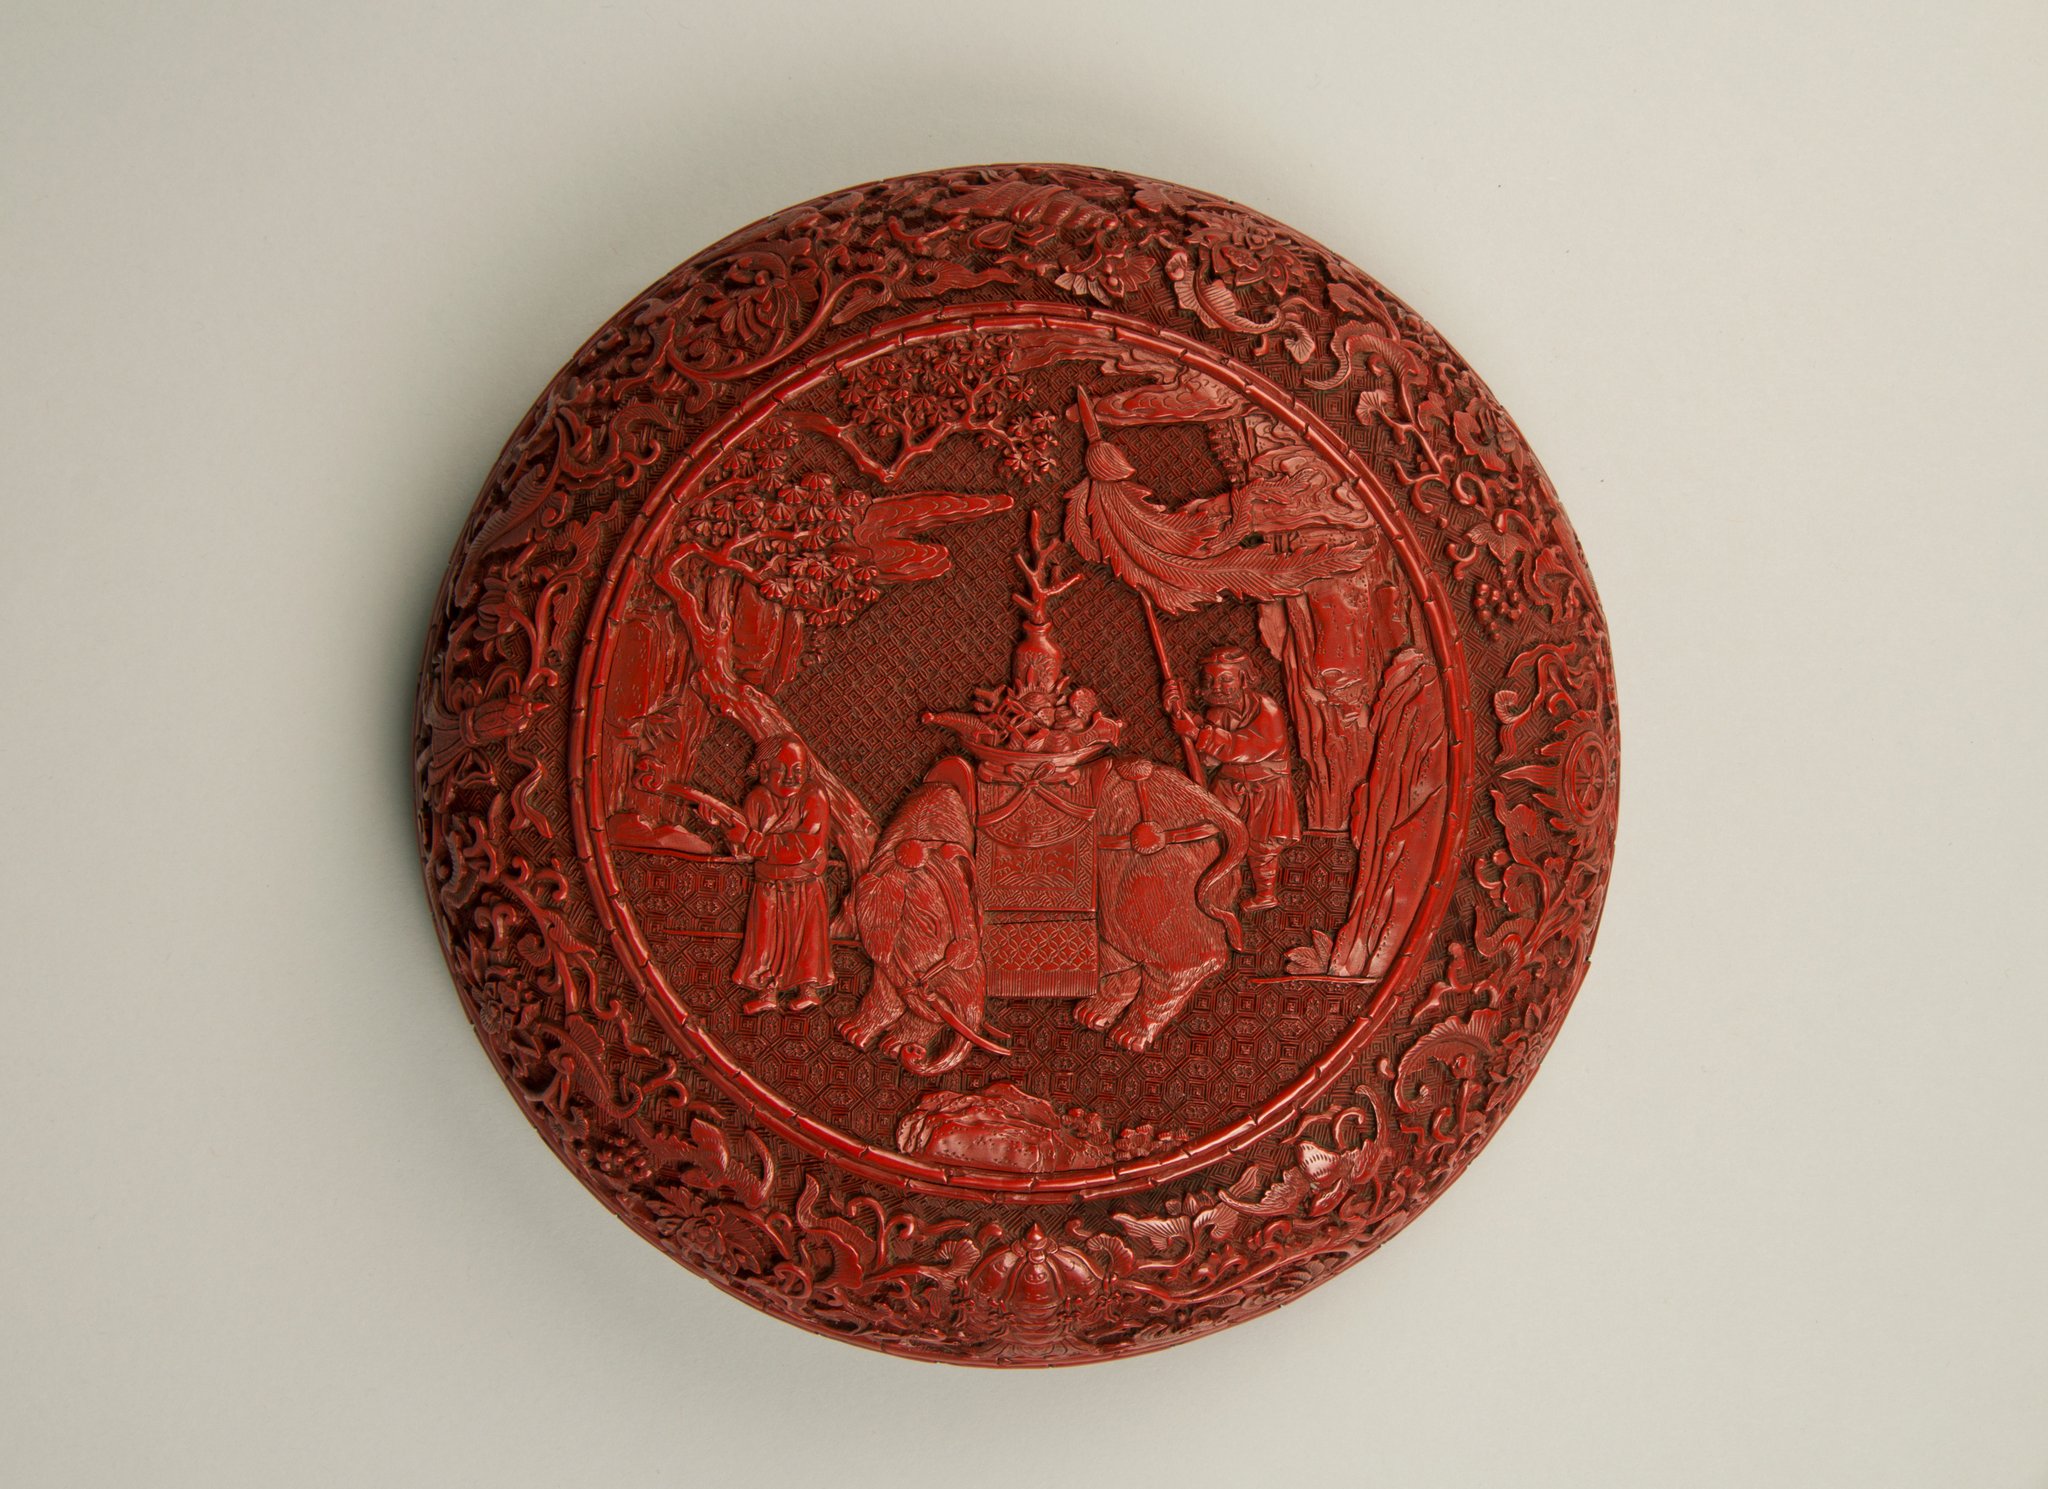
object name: box with cover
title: One of a pair of boxes with elephants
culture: chinese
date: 1736-1795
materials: lacquer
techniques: carving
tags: men